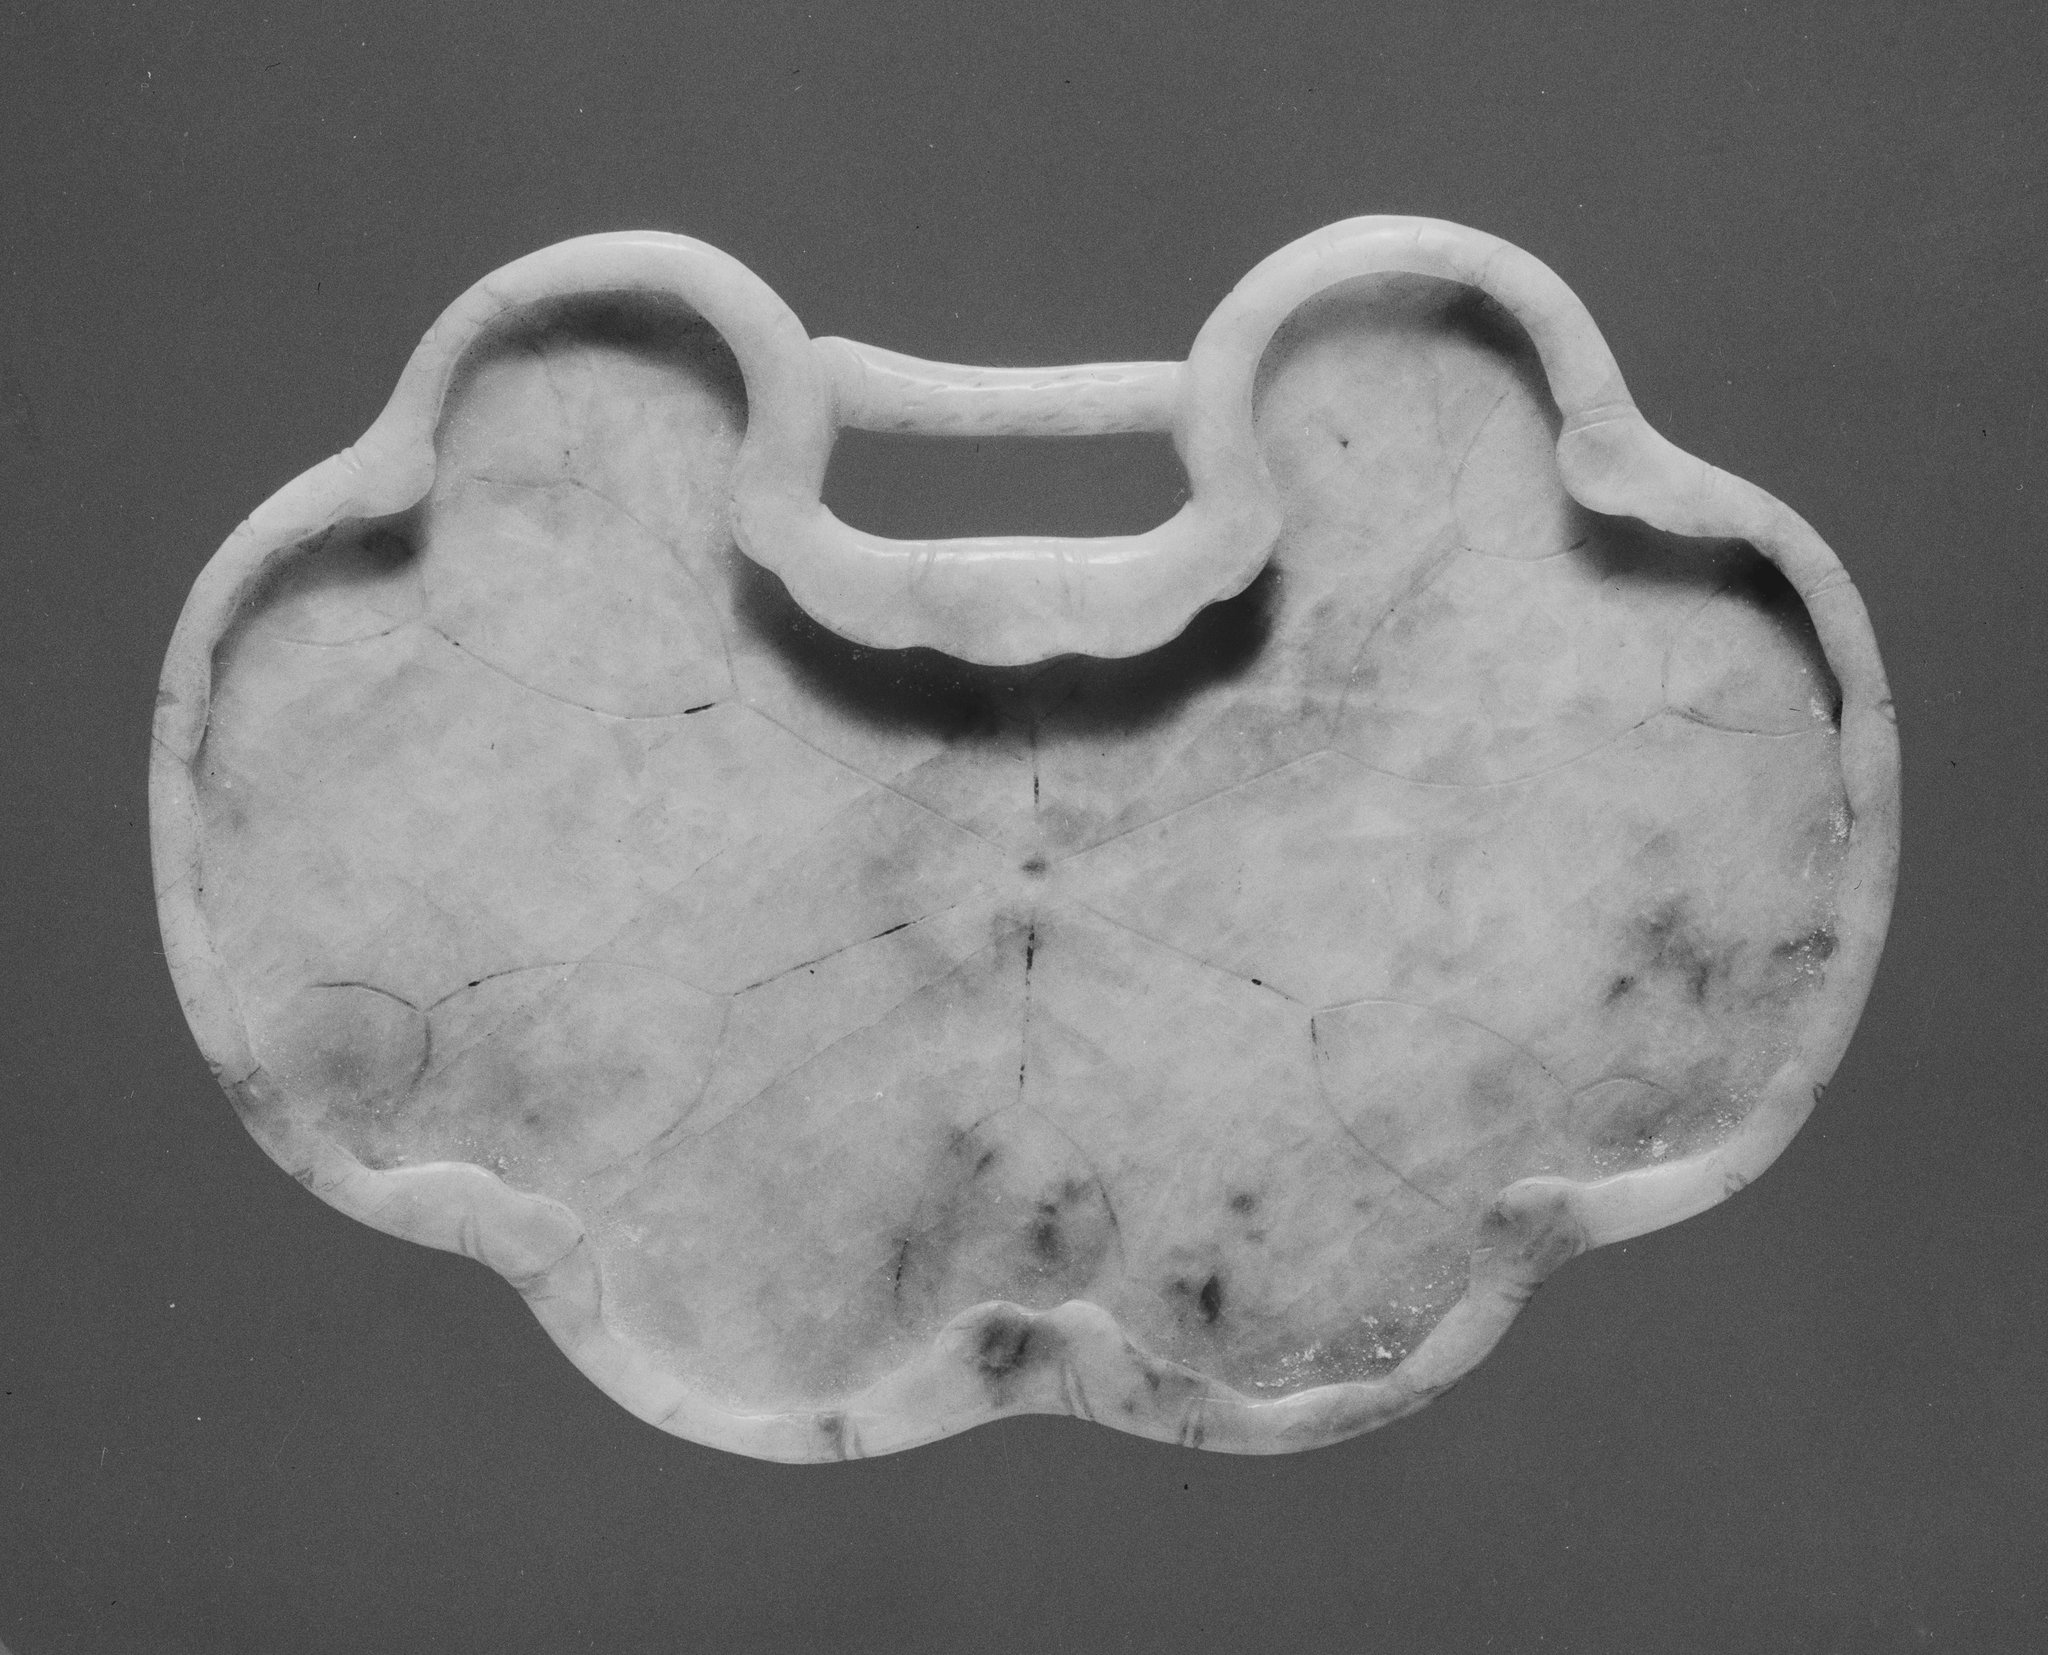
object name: dish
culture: chinese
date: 1644-1911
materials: jade